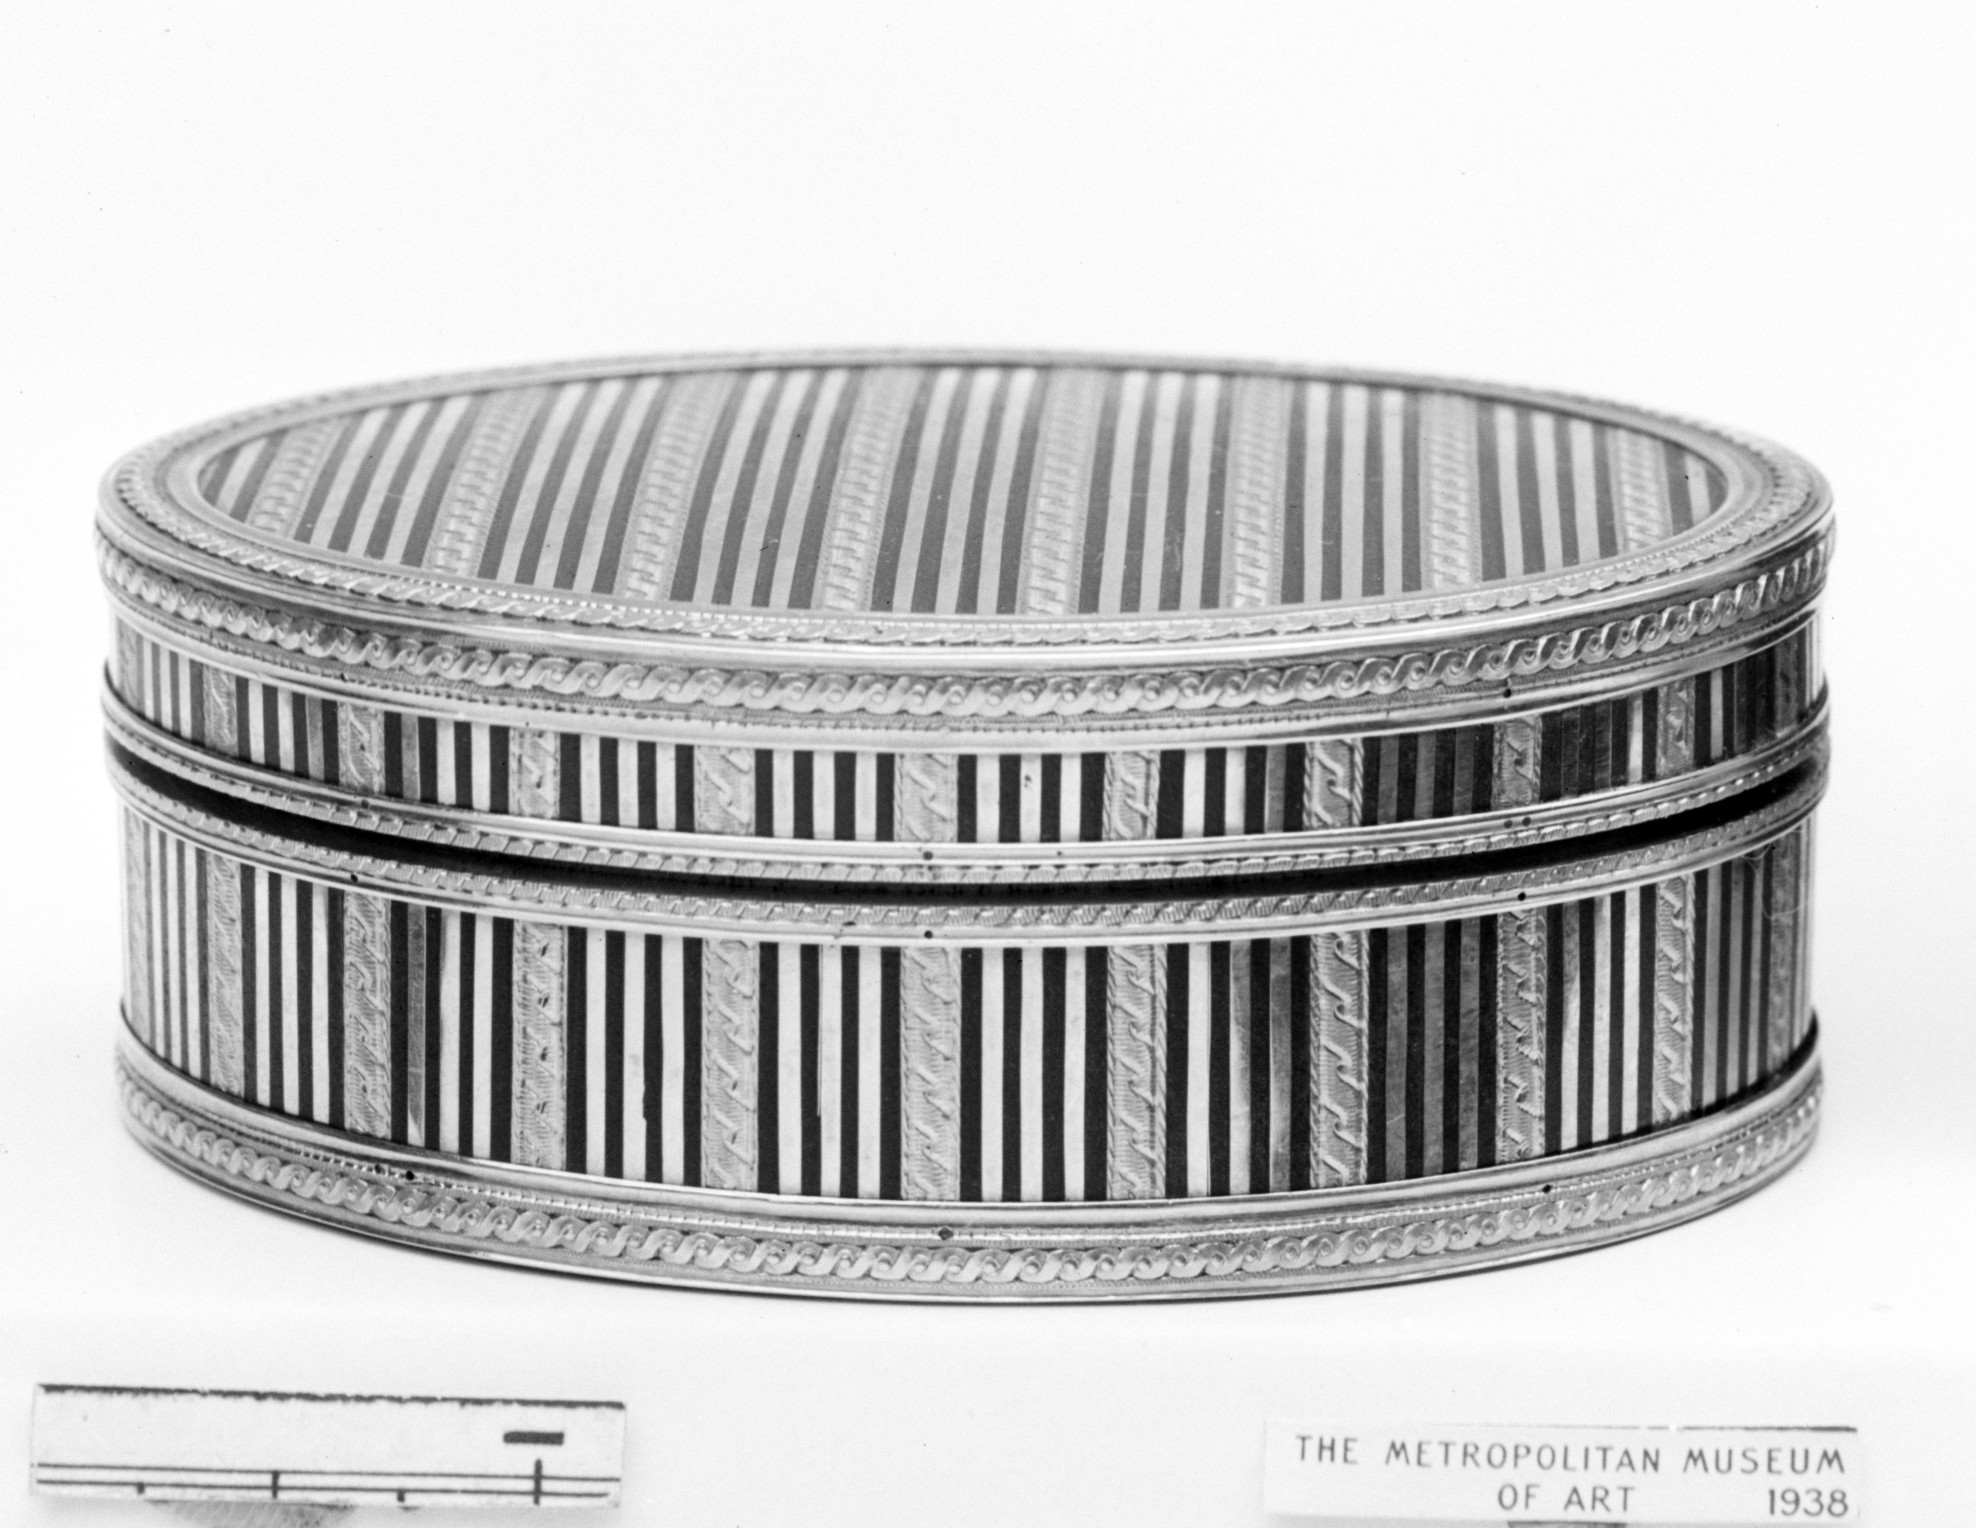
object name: snuffbox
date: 1768-1775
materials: gold, shell